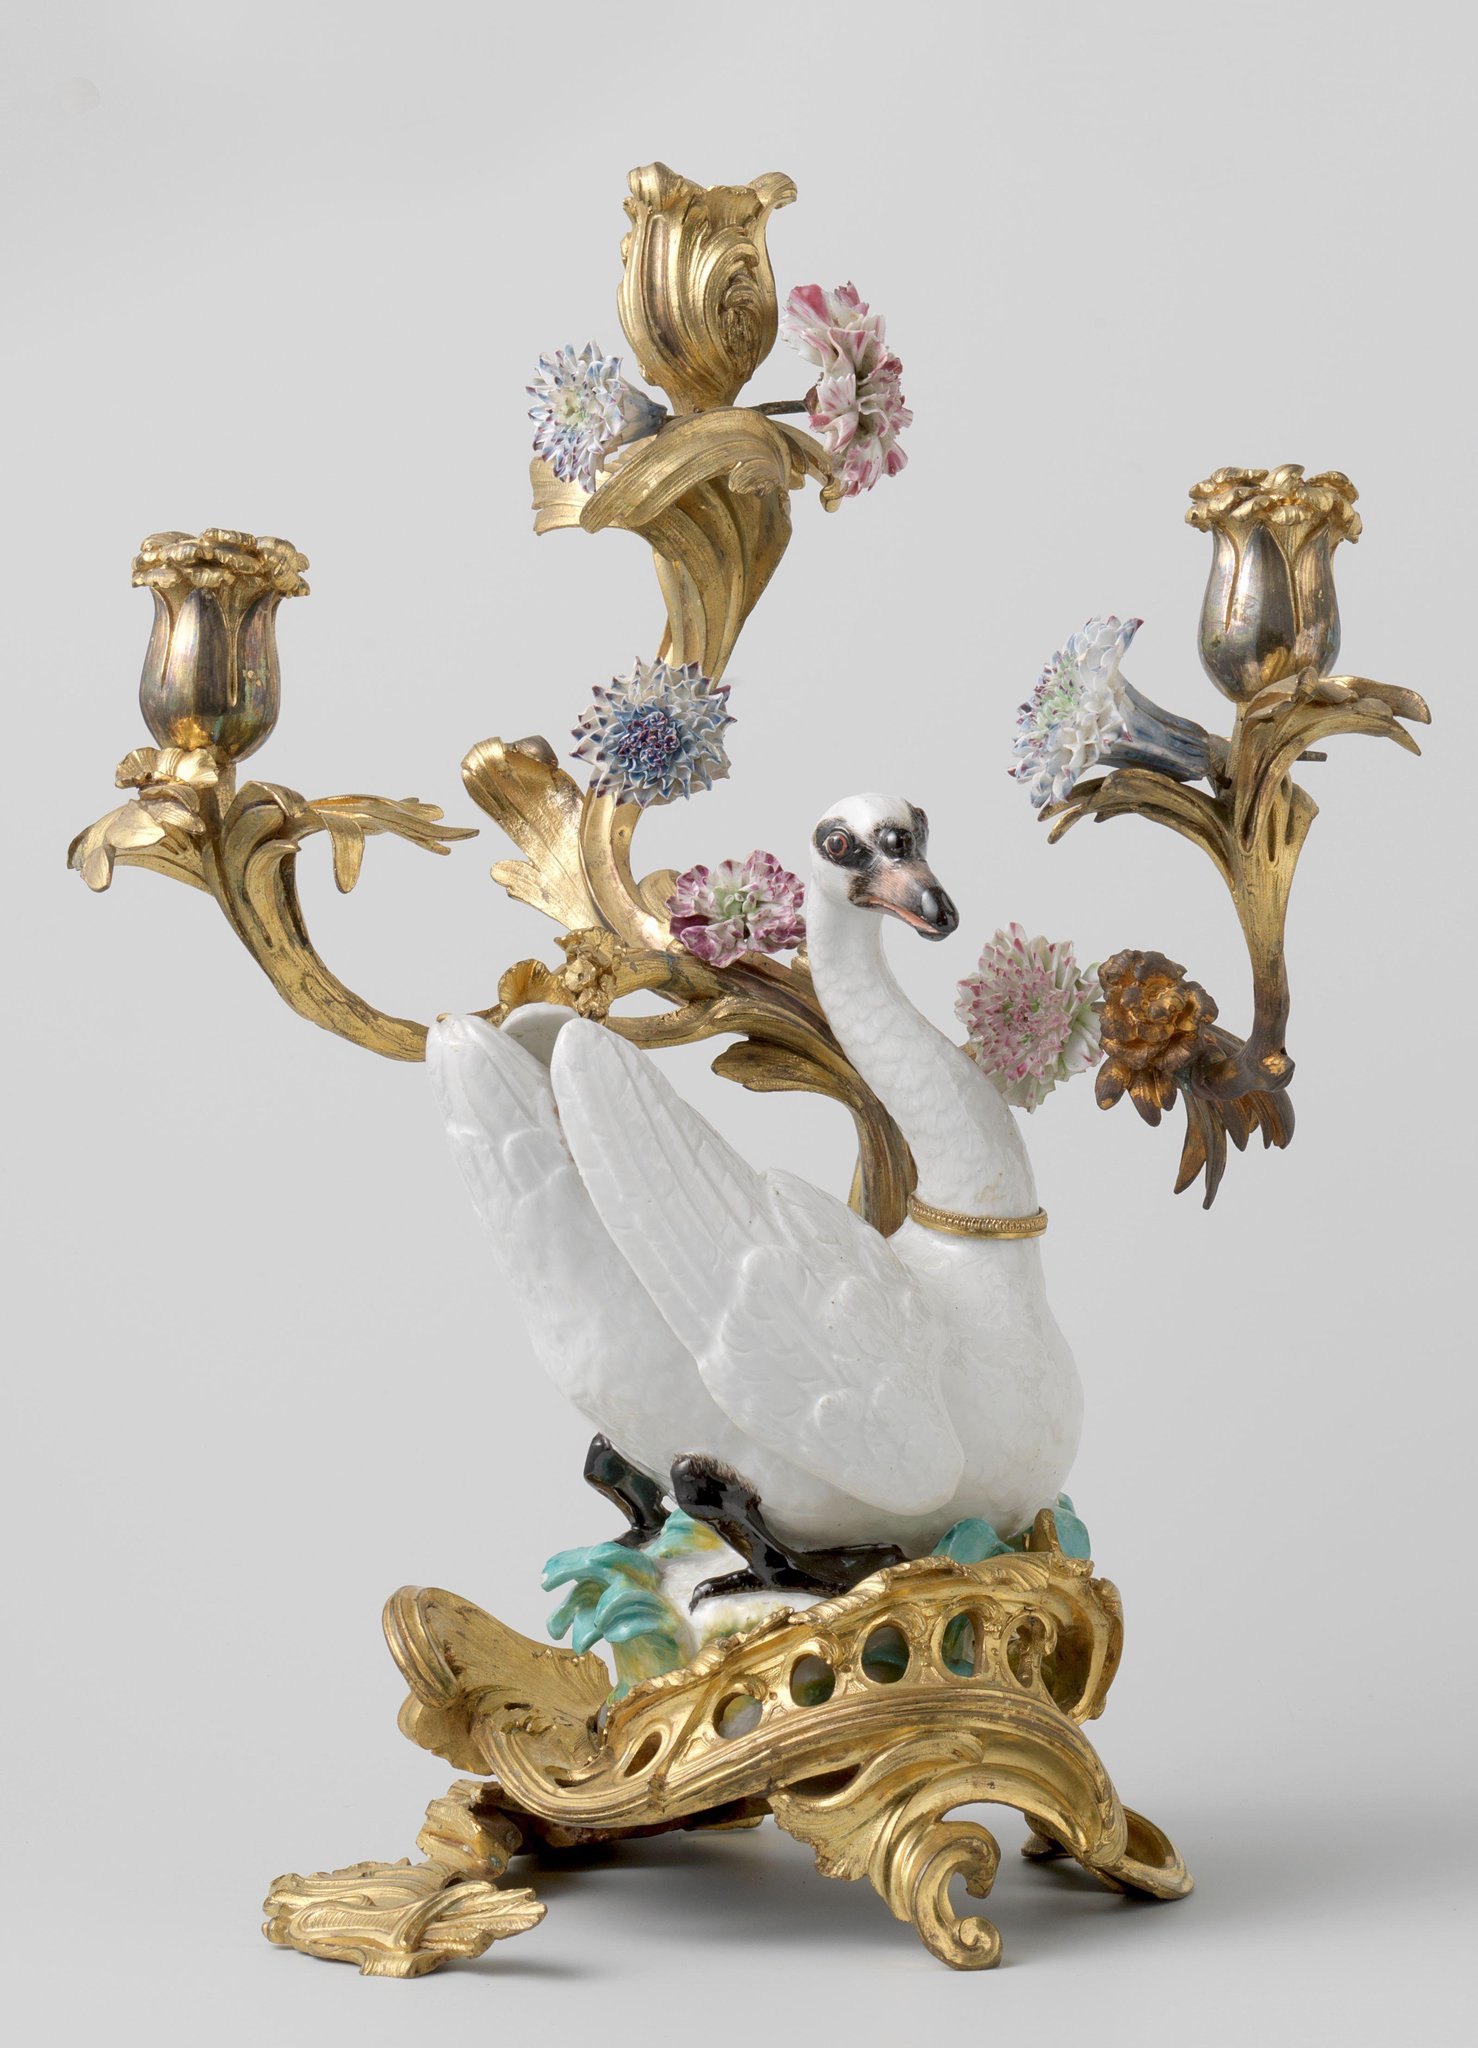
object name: candelabrum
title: Montuur van brons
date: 1748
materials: bronze, porcelain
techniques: gilding, painted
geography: meissen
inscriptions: factory mark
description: De zwaan is geplaatst in een verguld bronzen montuur in rococo-stijl, in de vorm van een drie-armige kandelaber, waaraan bloemen van porselein in blauw, roze, groen en violet zijn bevestigd.